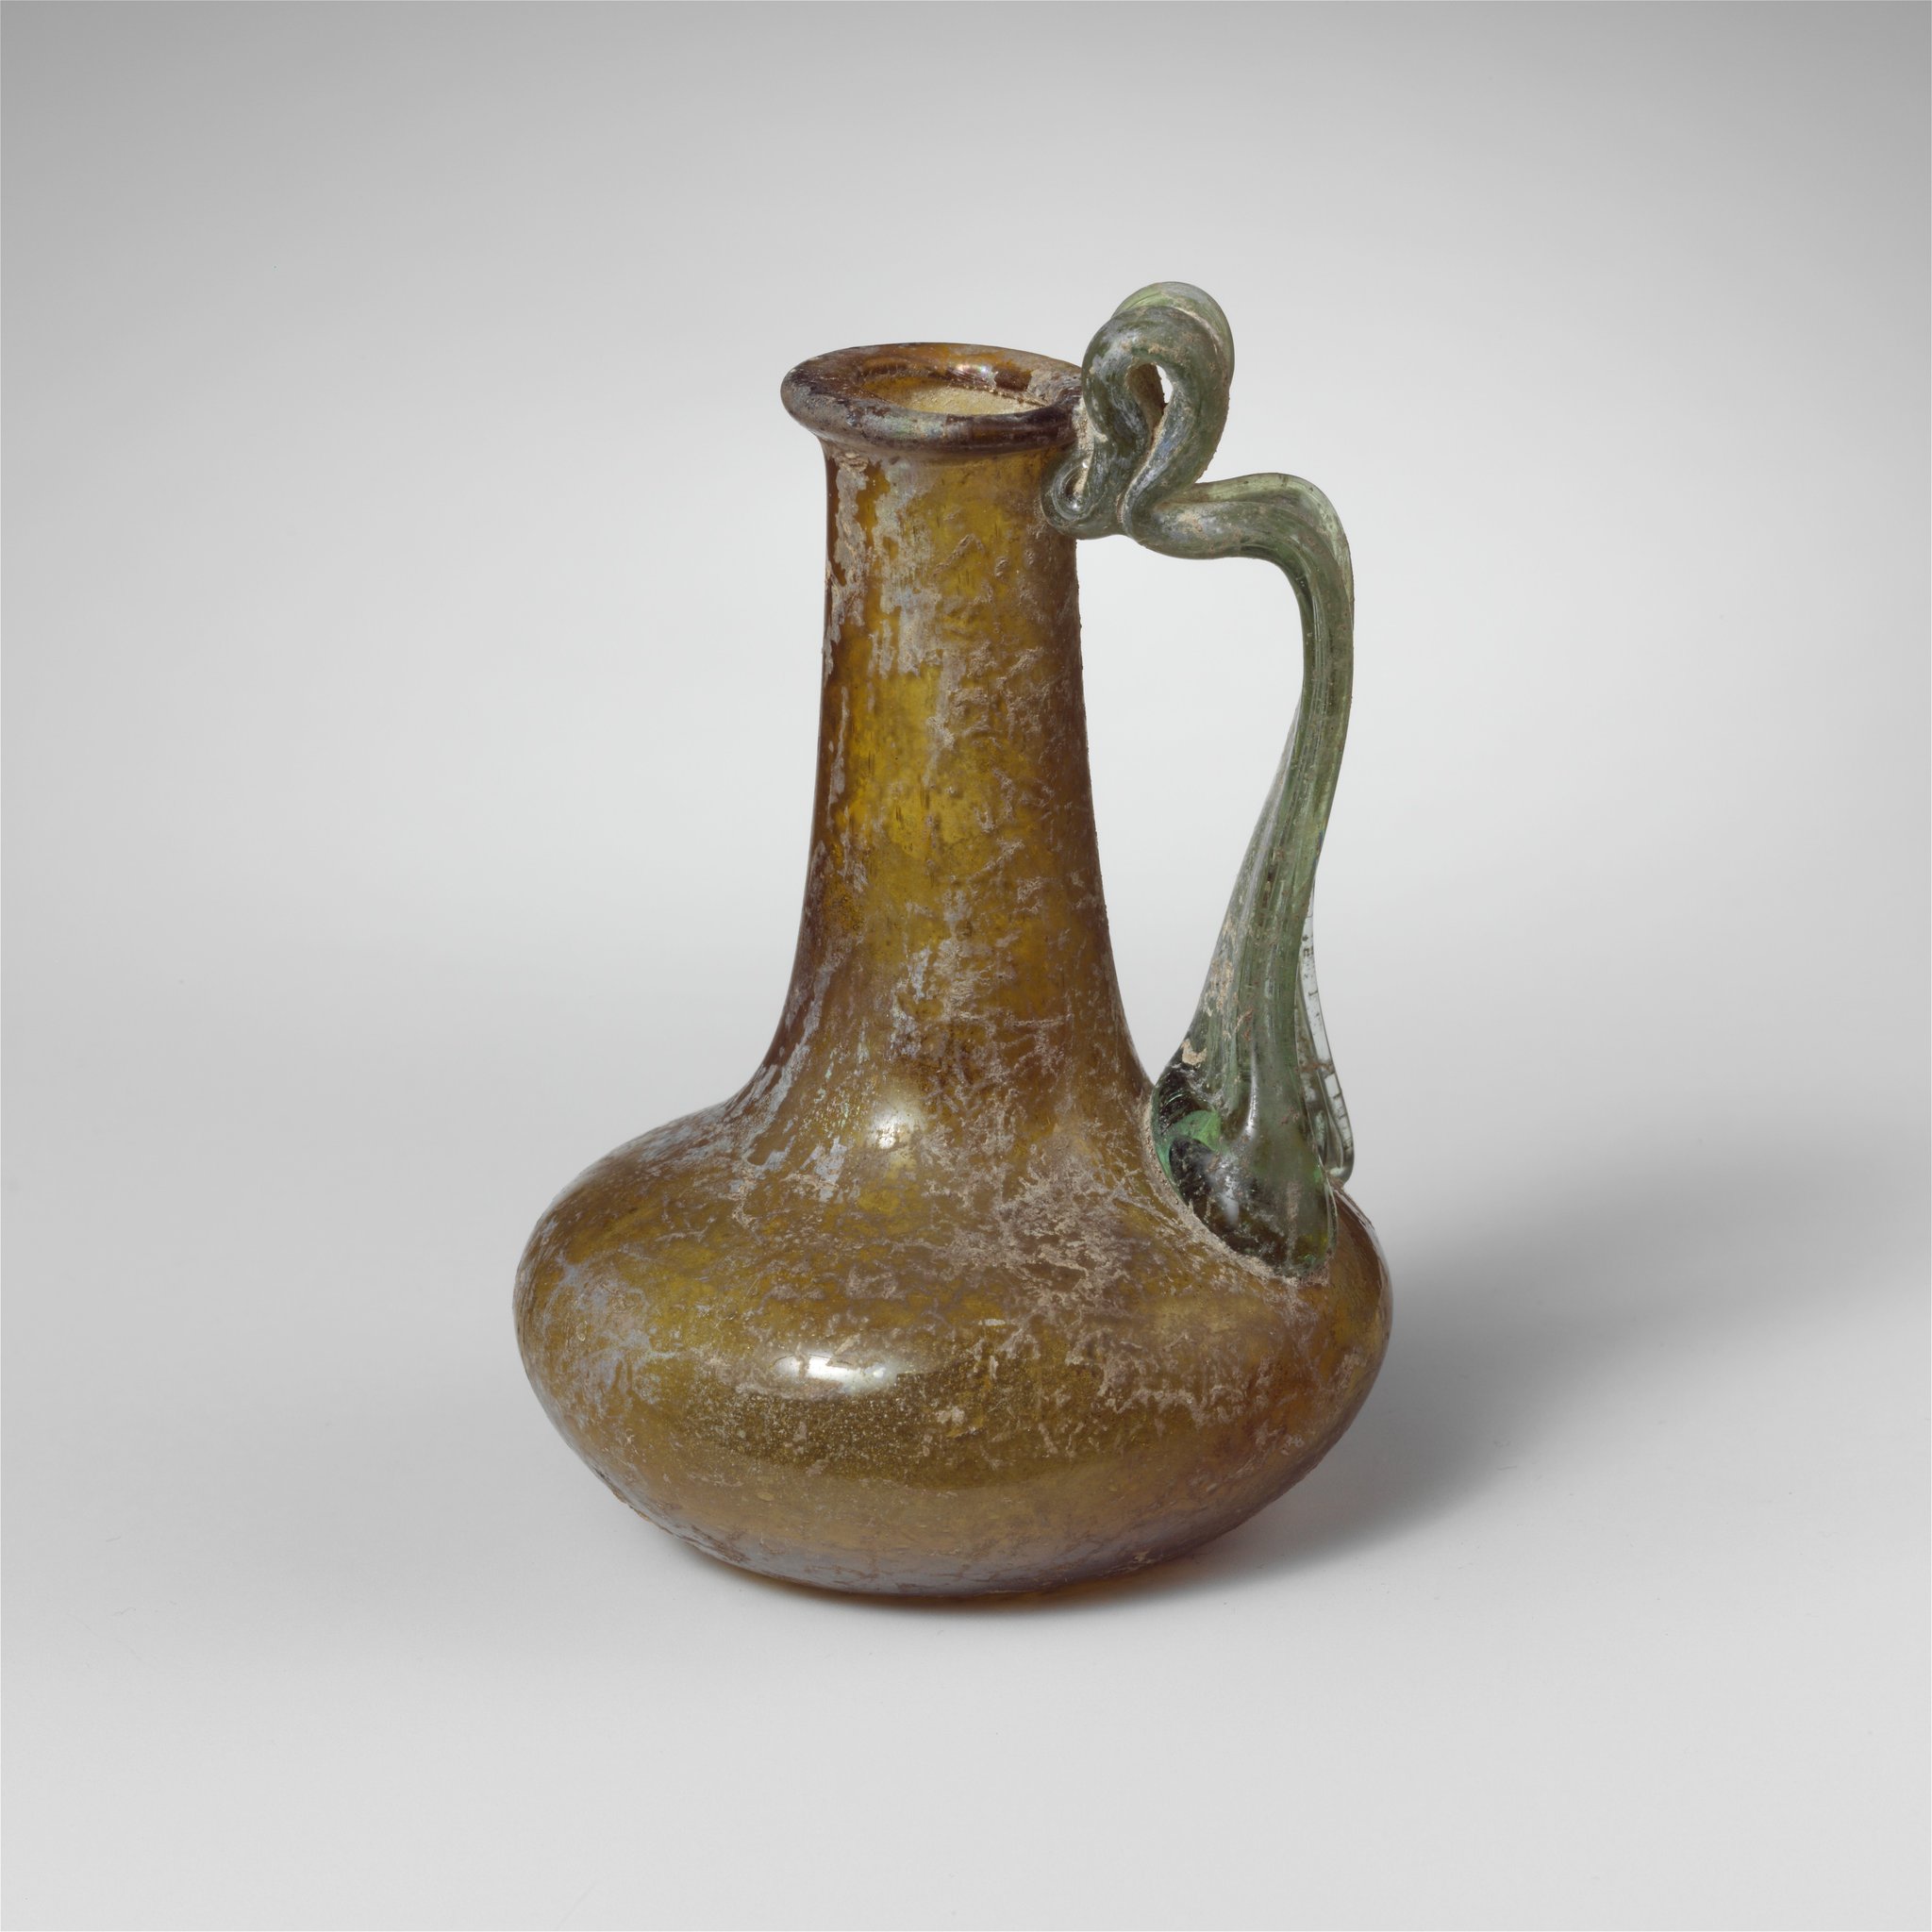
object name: jug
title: Glass jug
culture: roman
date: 1-200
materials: glass